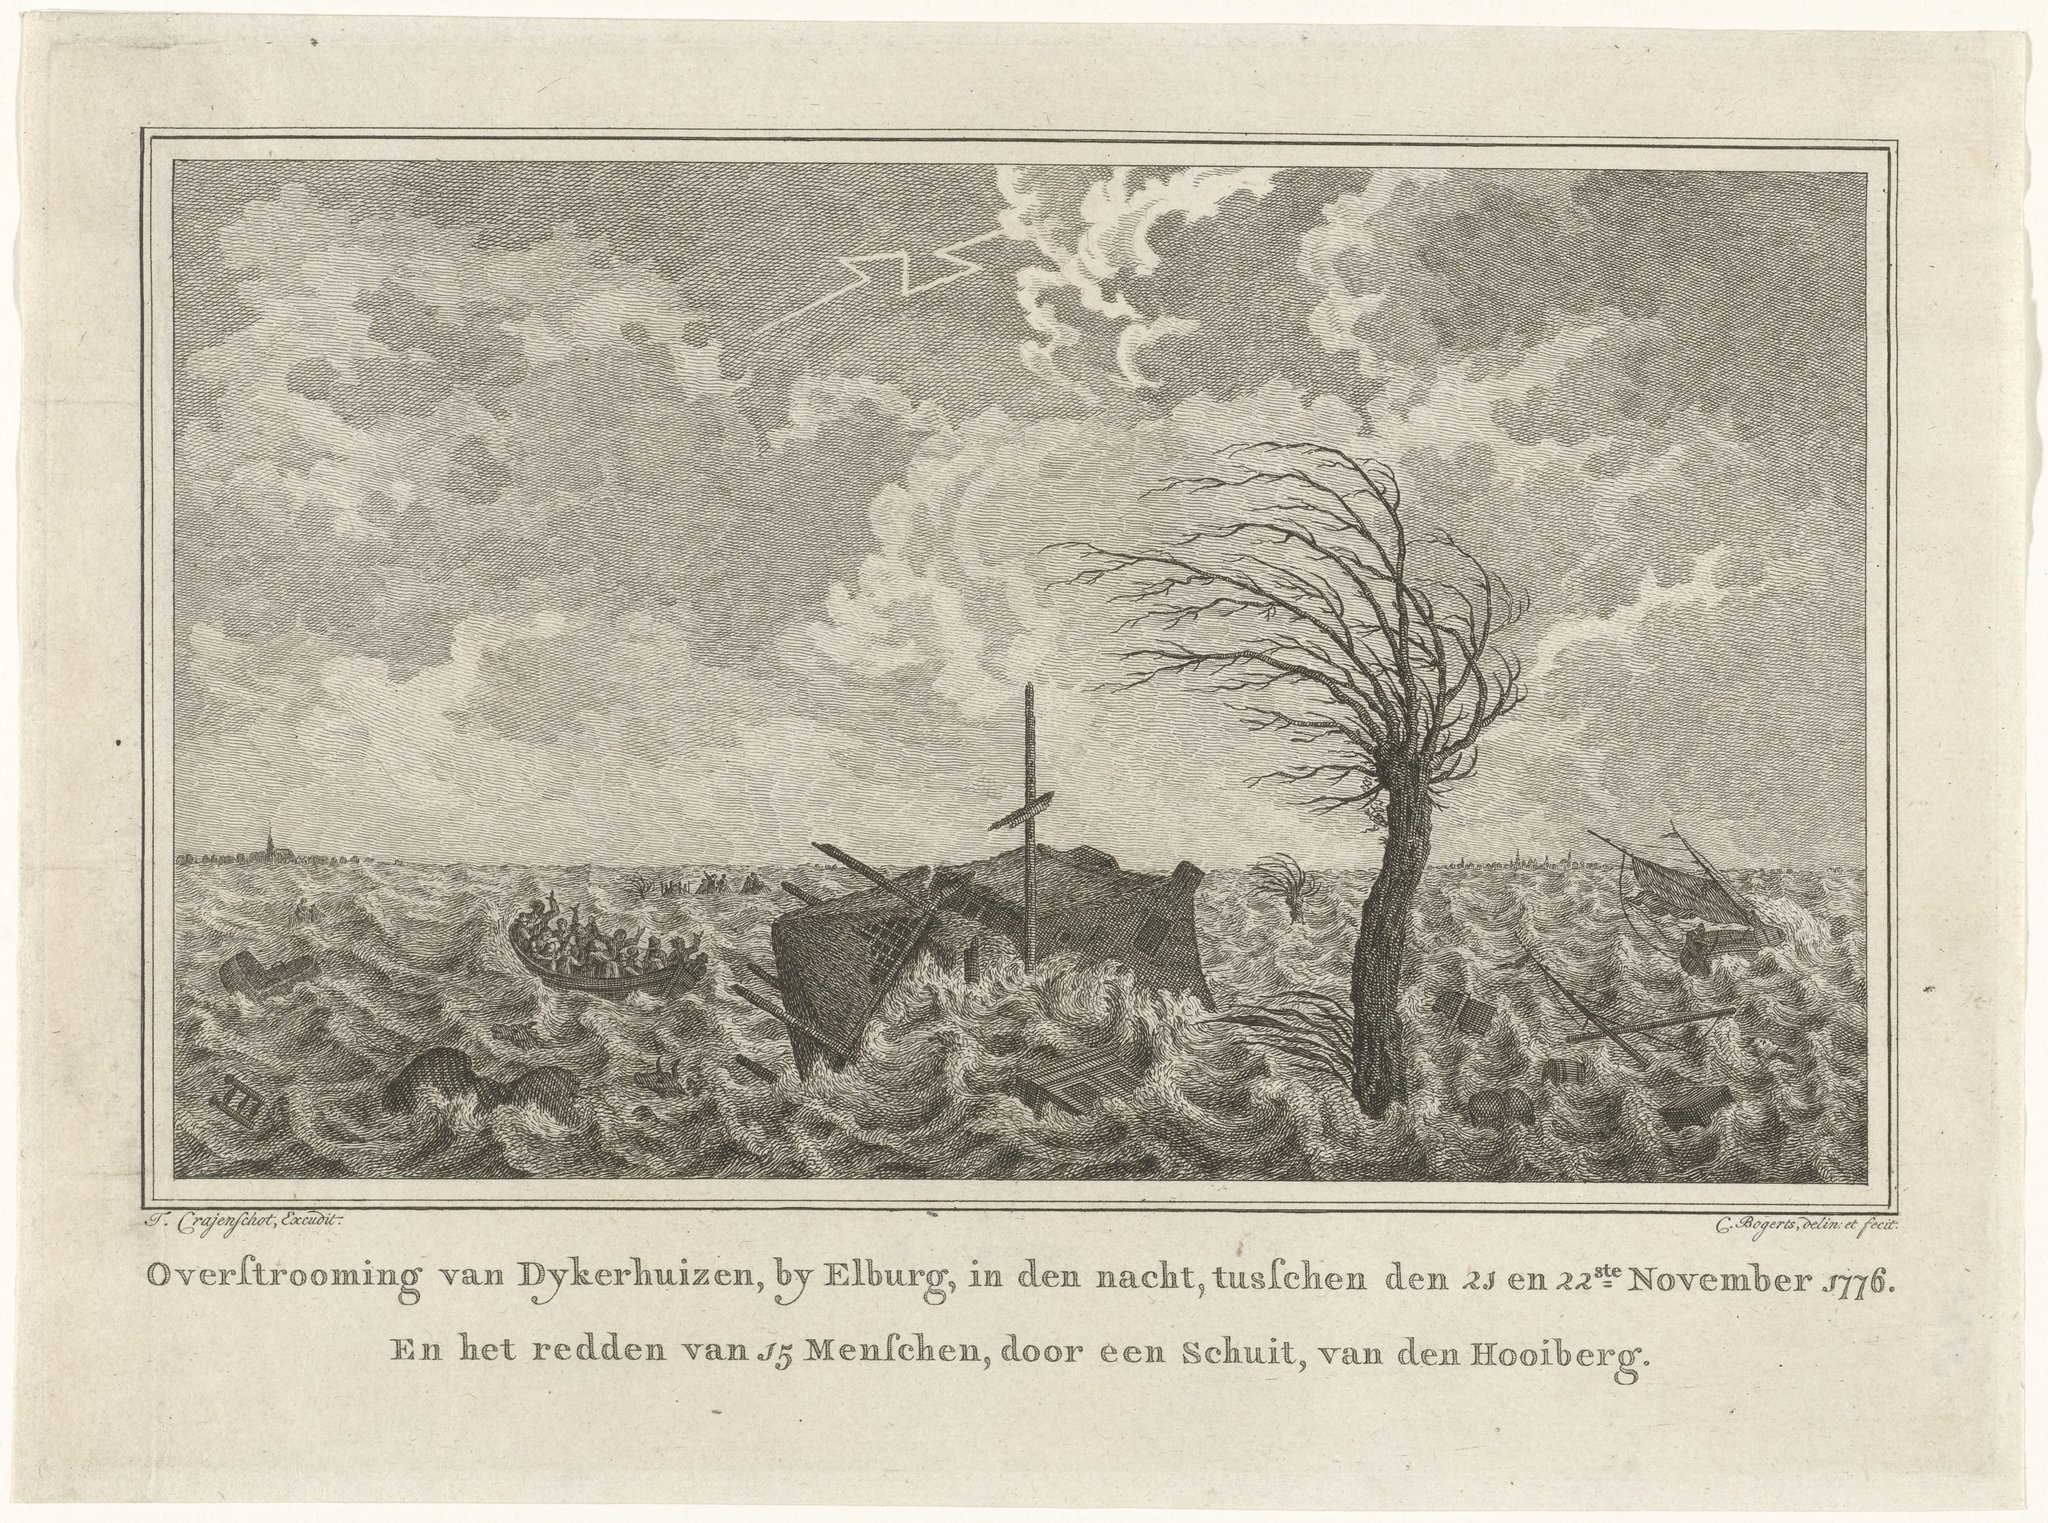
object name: print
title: Watersnood bij Elburg, 1776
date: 1776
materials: paper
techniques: engraving, etching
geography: northern netherlands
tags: flood, storm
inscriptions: collector's mark: Lugt 2228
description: Watersnood en overstroming van het dorp Dijkerhuizen bij Elburg en de redding van 15 personen met een schuit, 21-22 november 1776.